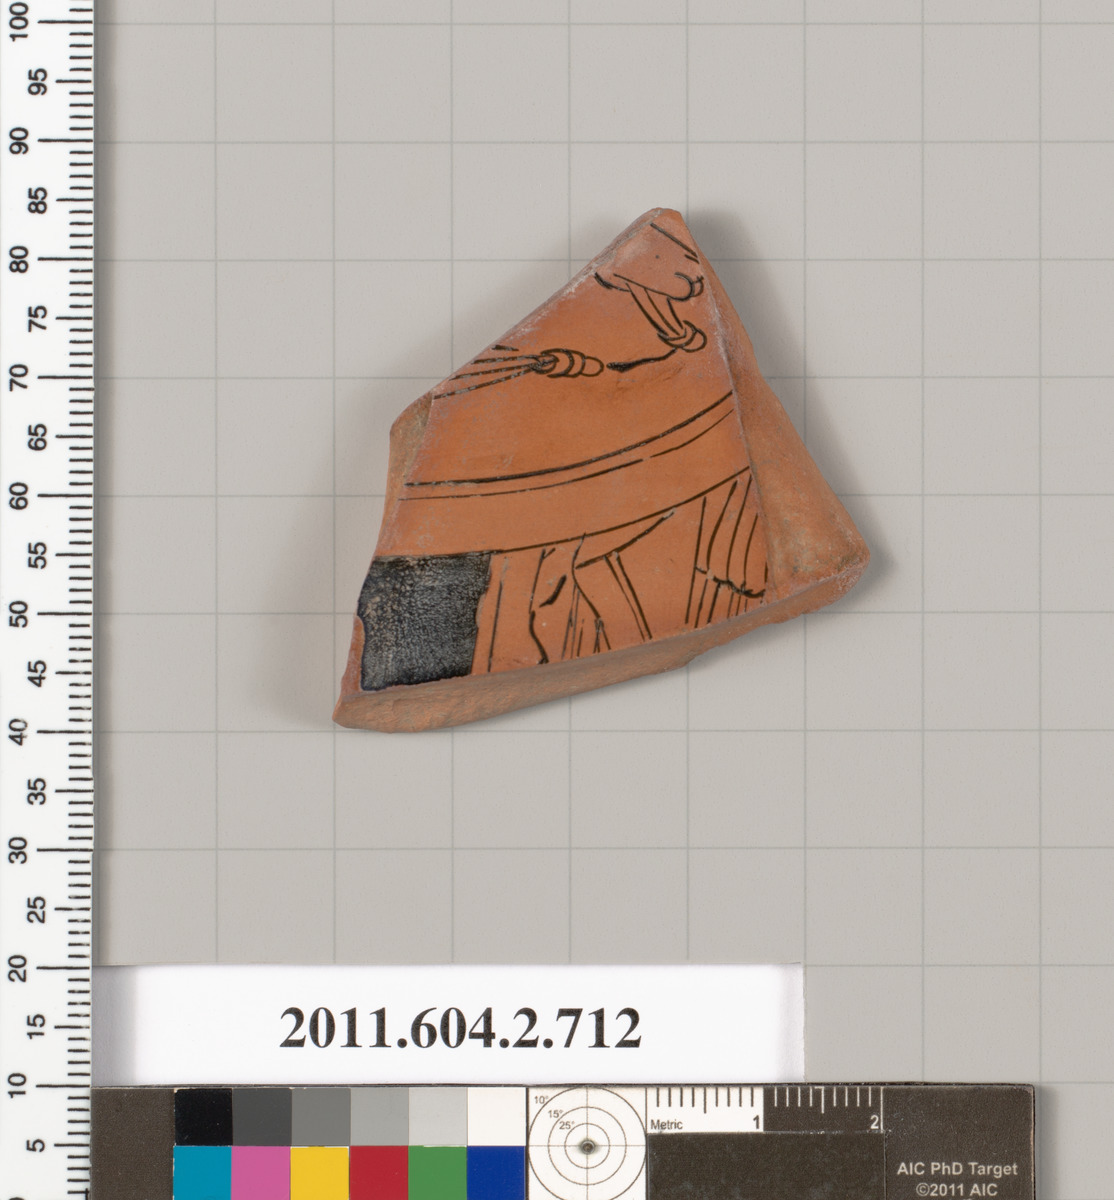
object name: calyx krater fragment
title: Terracotta fragment of a calyx-krater (bowl for mixing wine and water)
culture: greek, attic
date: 470-460 BCE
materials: terracotta